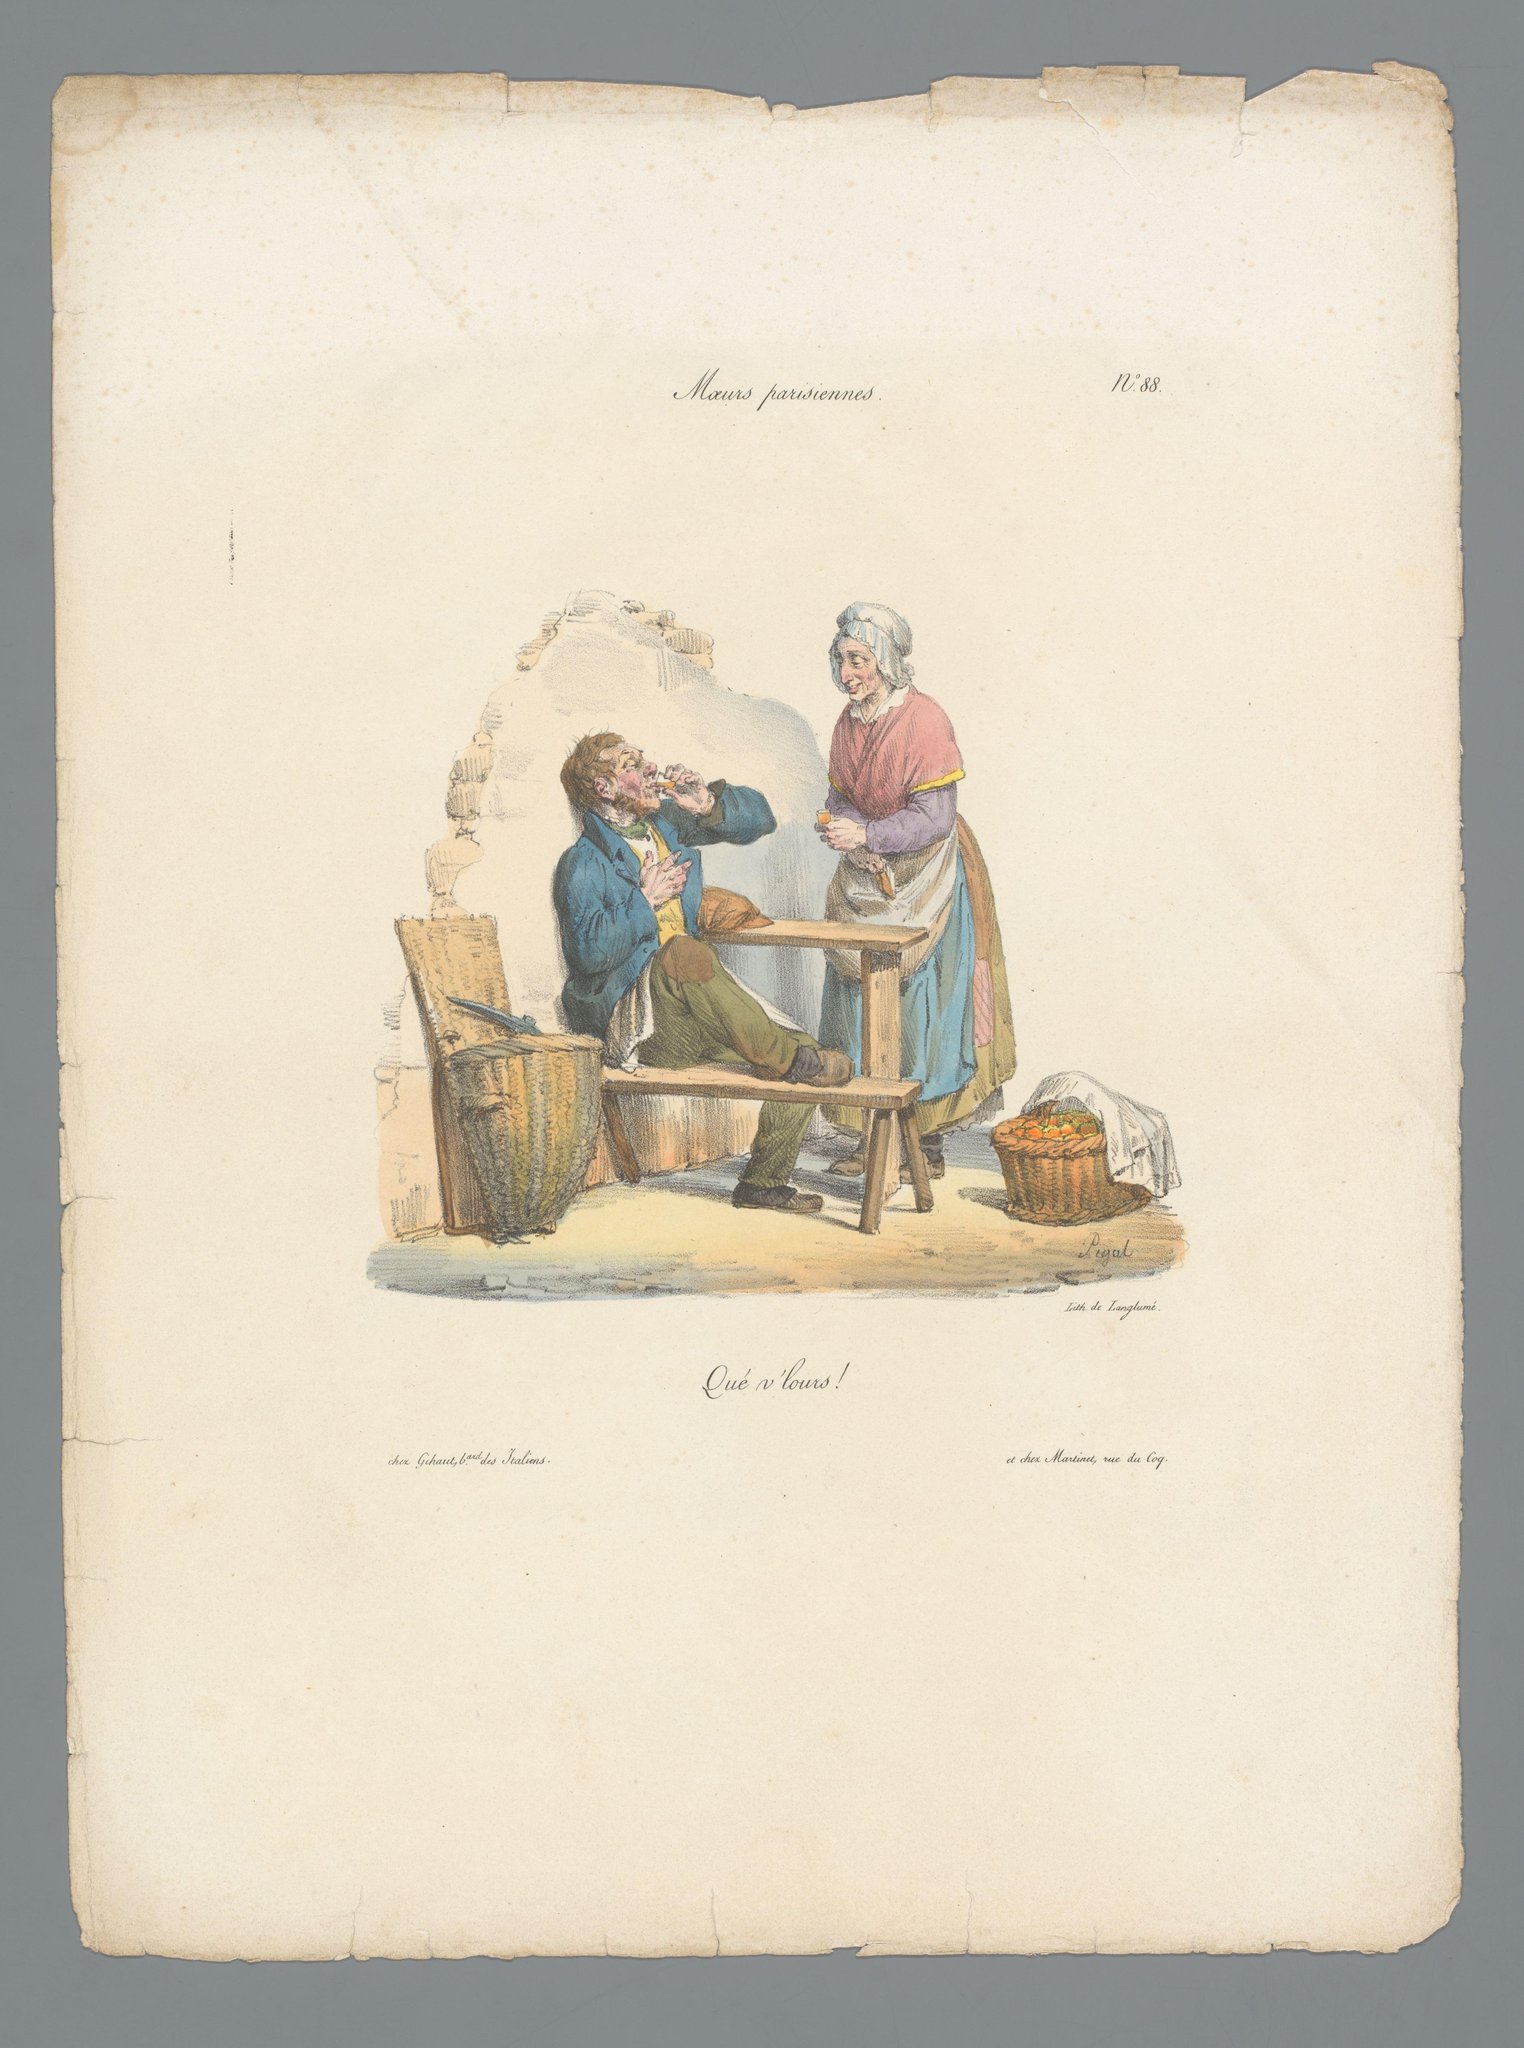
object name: print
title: Moeurs parisiennes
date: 1828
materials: paper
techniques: hand coloring, lithograph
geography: paris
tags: adult woman, adult man, drinking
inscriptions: collector's mark: Lugt 2228